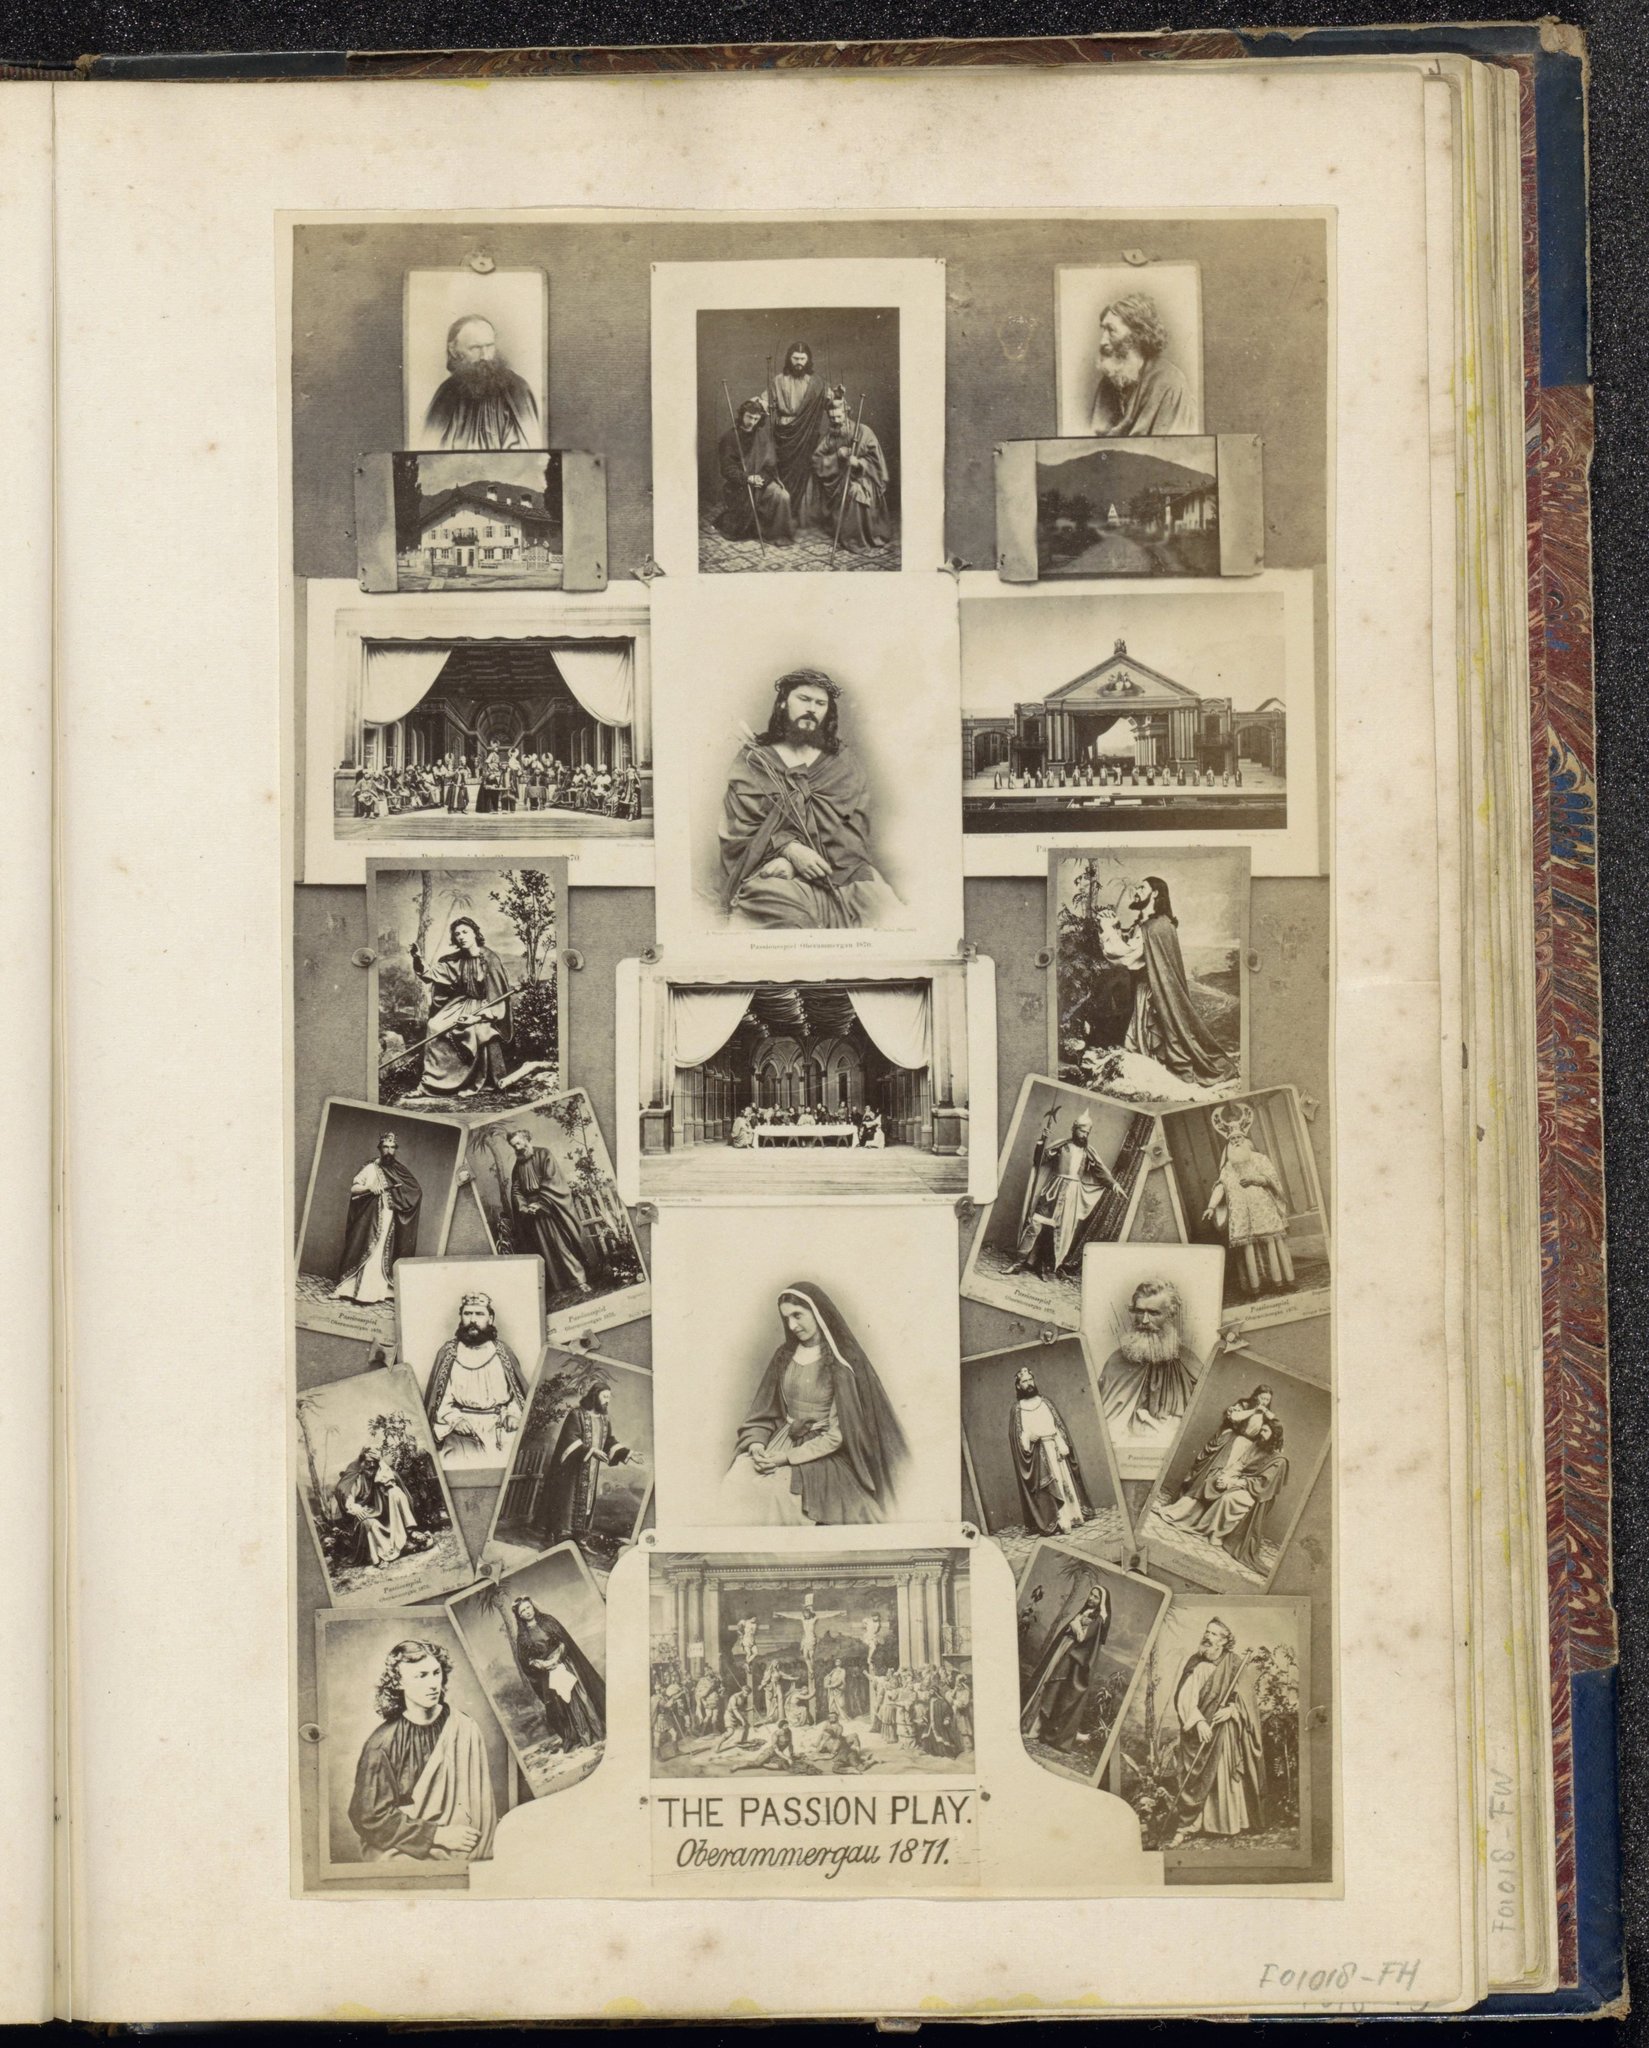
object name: reproduction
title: Fotoreproductie van een fotocollage of een affiche van de Passiespelen in Oberammergau van 1871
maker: Anonymous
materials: paper, photographic support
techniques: albumen print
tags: religious drama, poster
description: Onderdeel van Engels familiealbum met foto's van personen, reizen, cricket en kunstwerken.